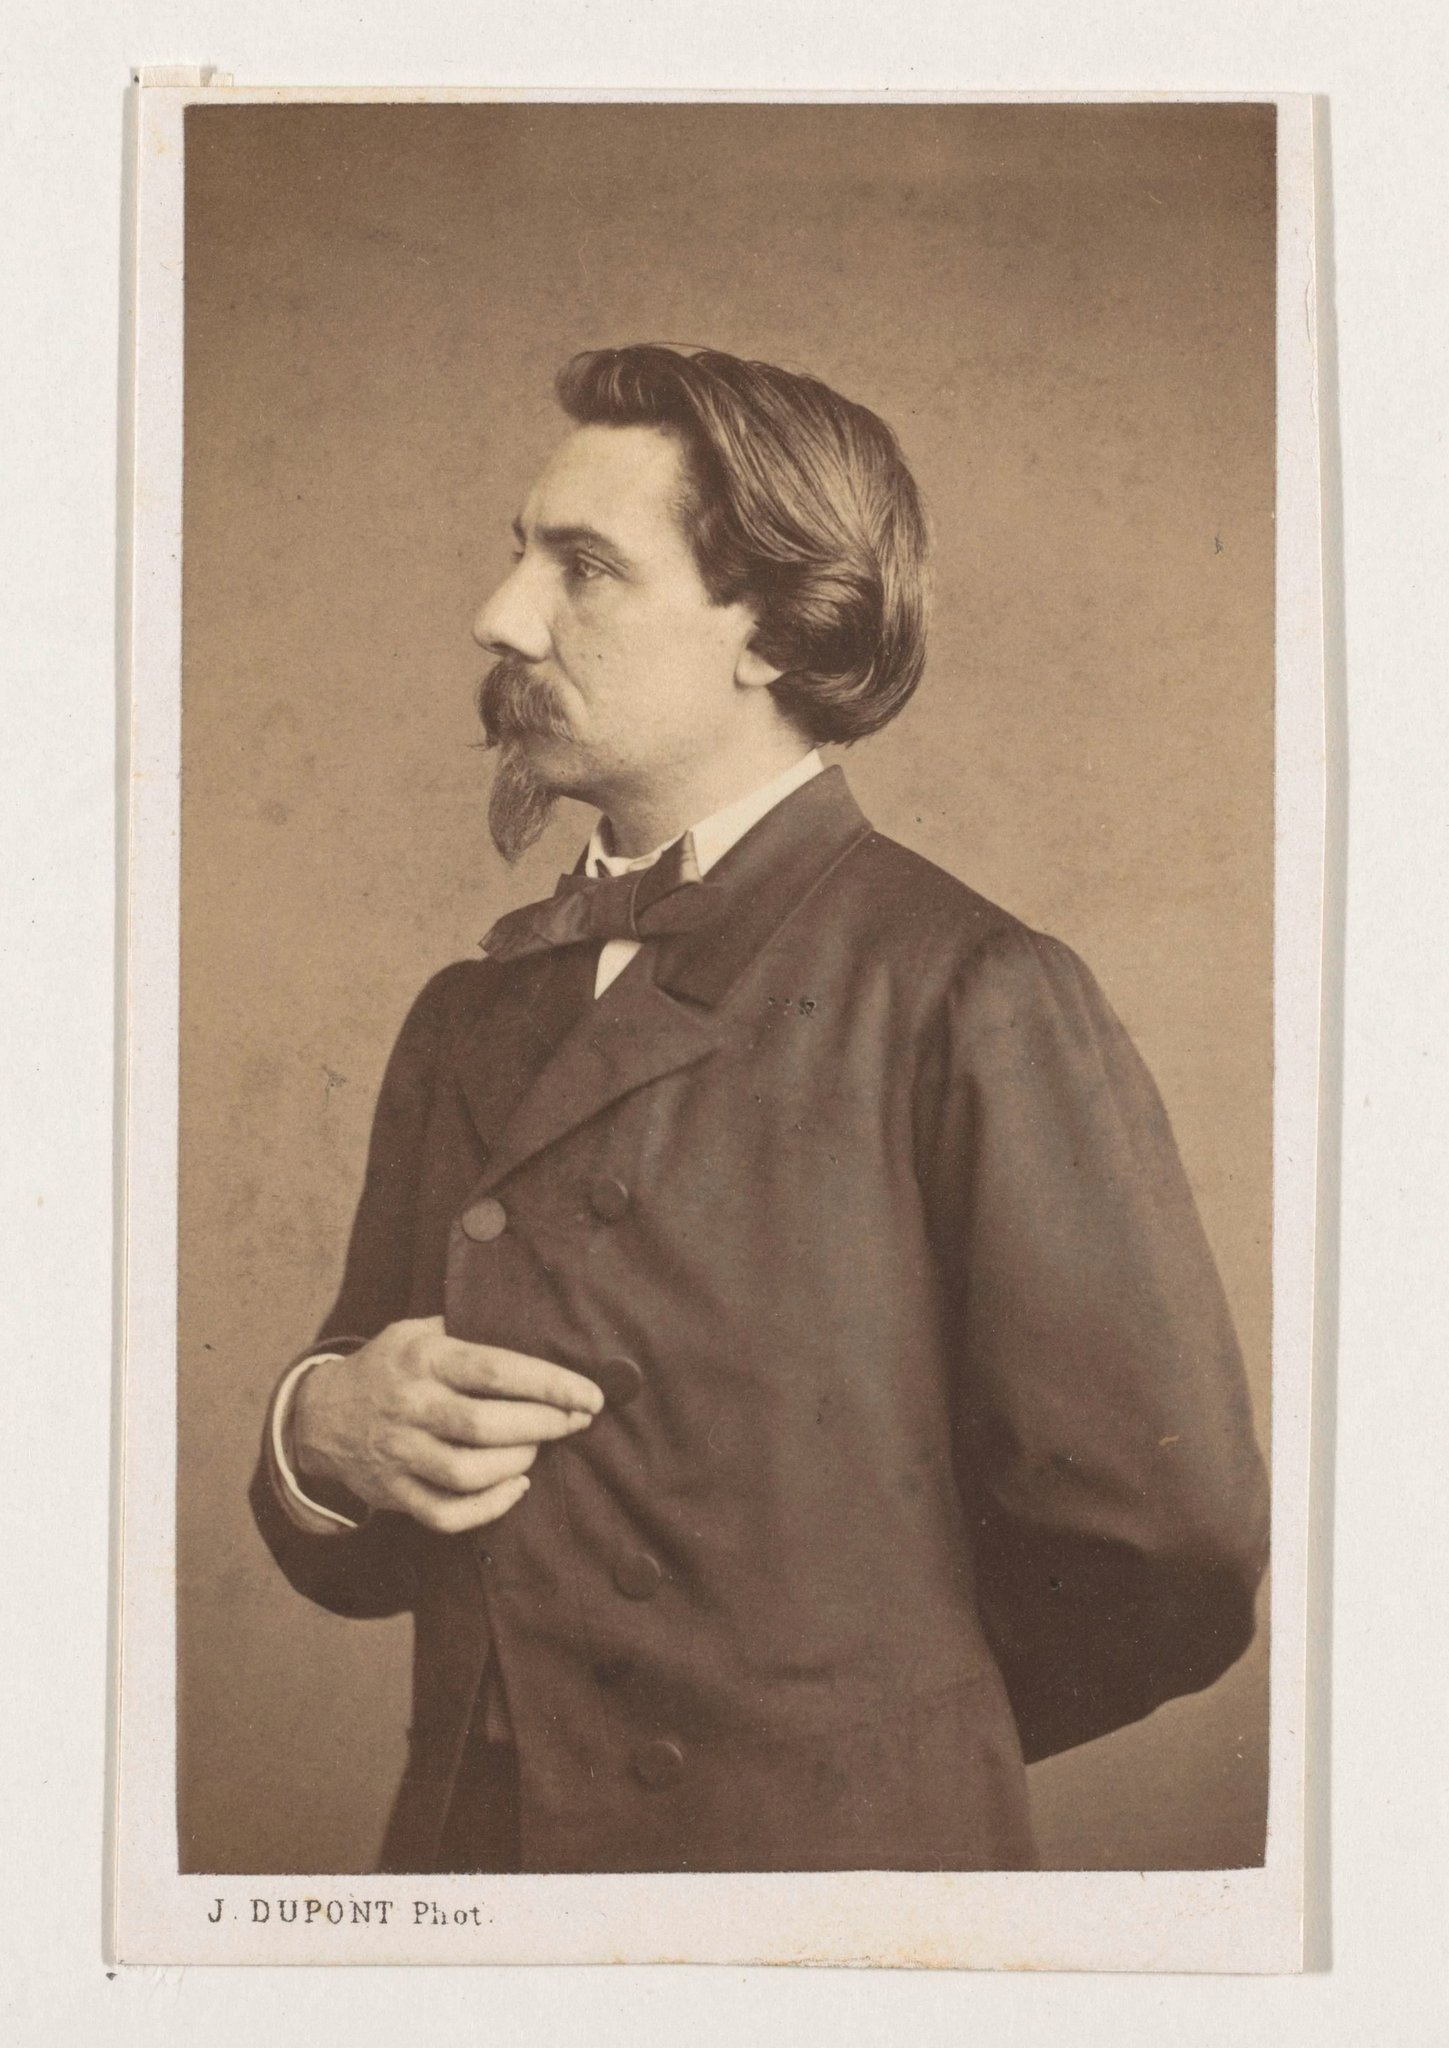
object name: photograph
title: L'École d'Anvers. Portraits biographies cartes de visite. Collection Dupont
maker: joseph dupont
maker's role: fotograaf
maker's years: 1818-1901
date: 1861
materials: cardboard, paper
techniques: albumen print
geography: antwerp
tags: antwerp, painter, henri bource, historical persons, portrait, self-portrait of painter, portrait, self-portrait of artist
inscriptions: inscription: ‘ETABLISSEMENT PHOTOGRAPHIQUE/ de/ J. DUPONT/ Place de Meir 32/ ANVERS/ Maison fondée en 1853’